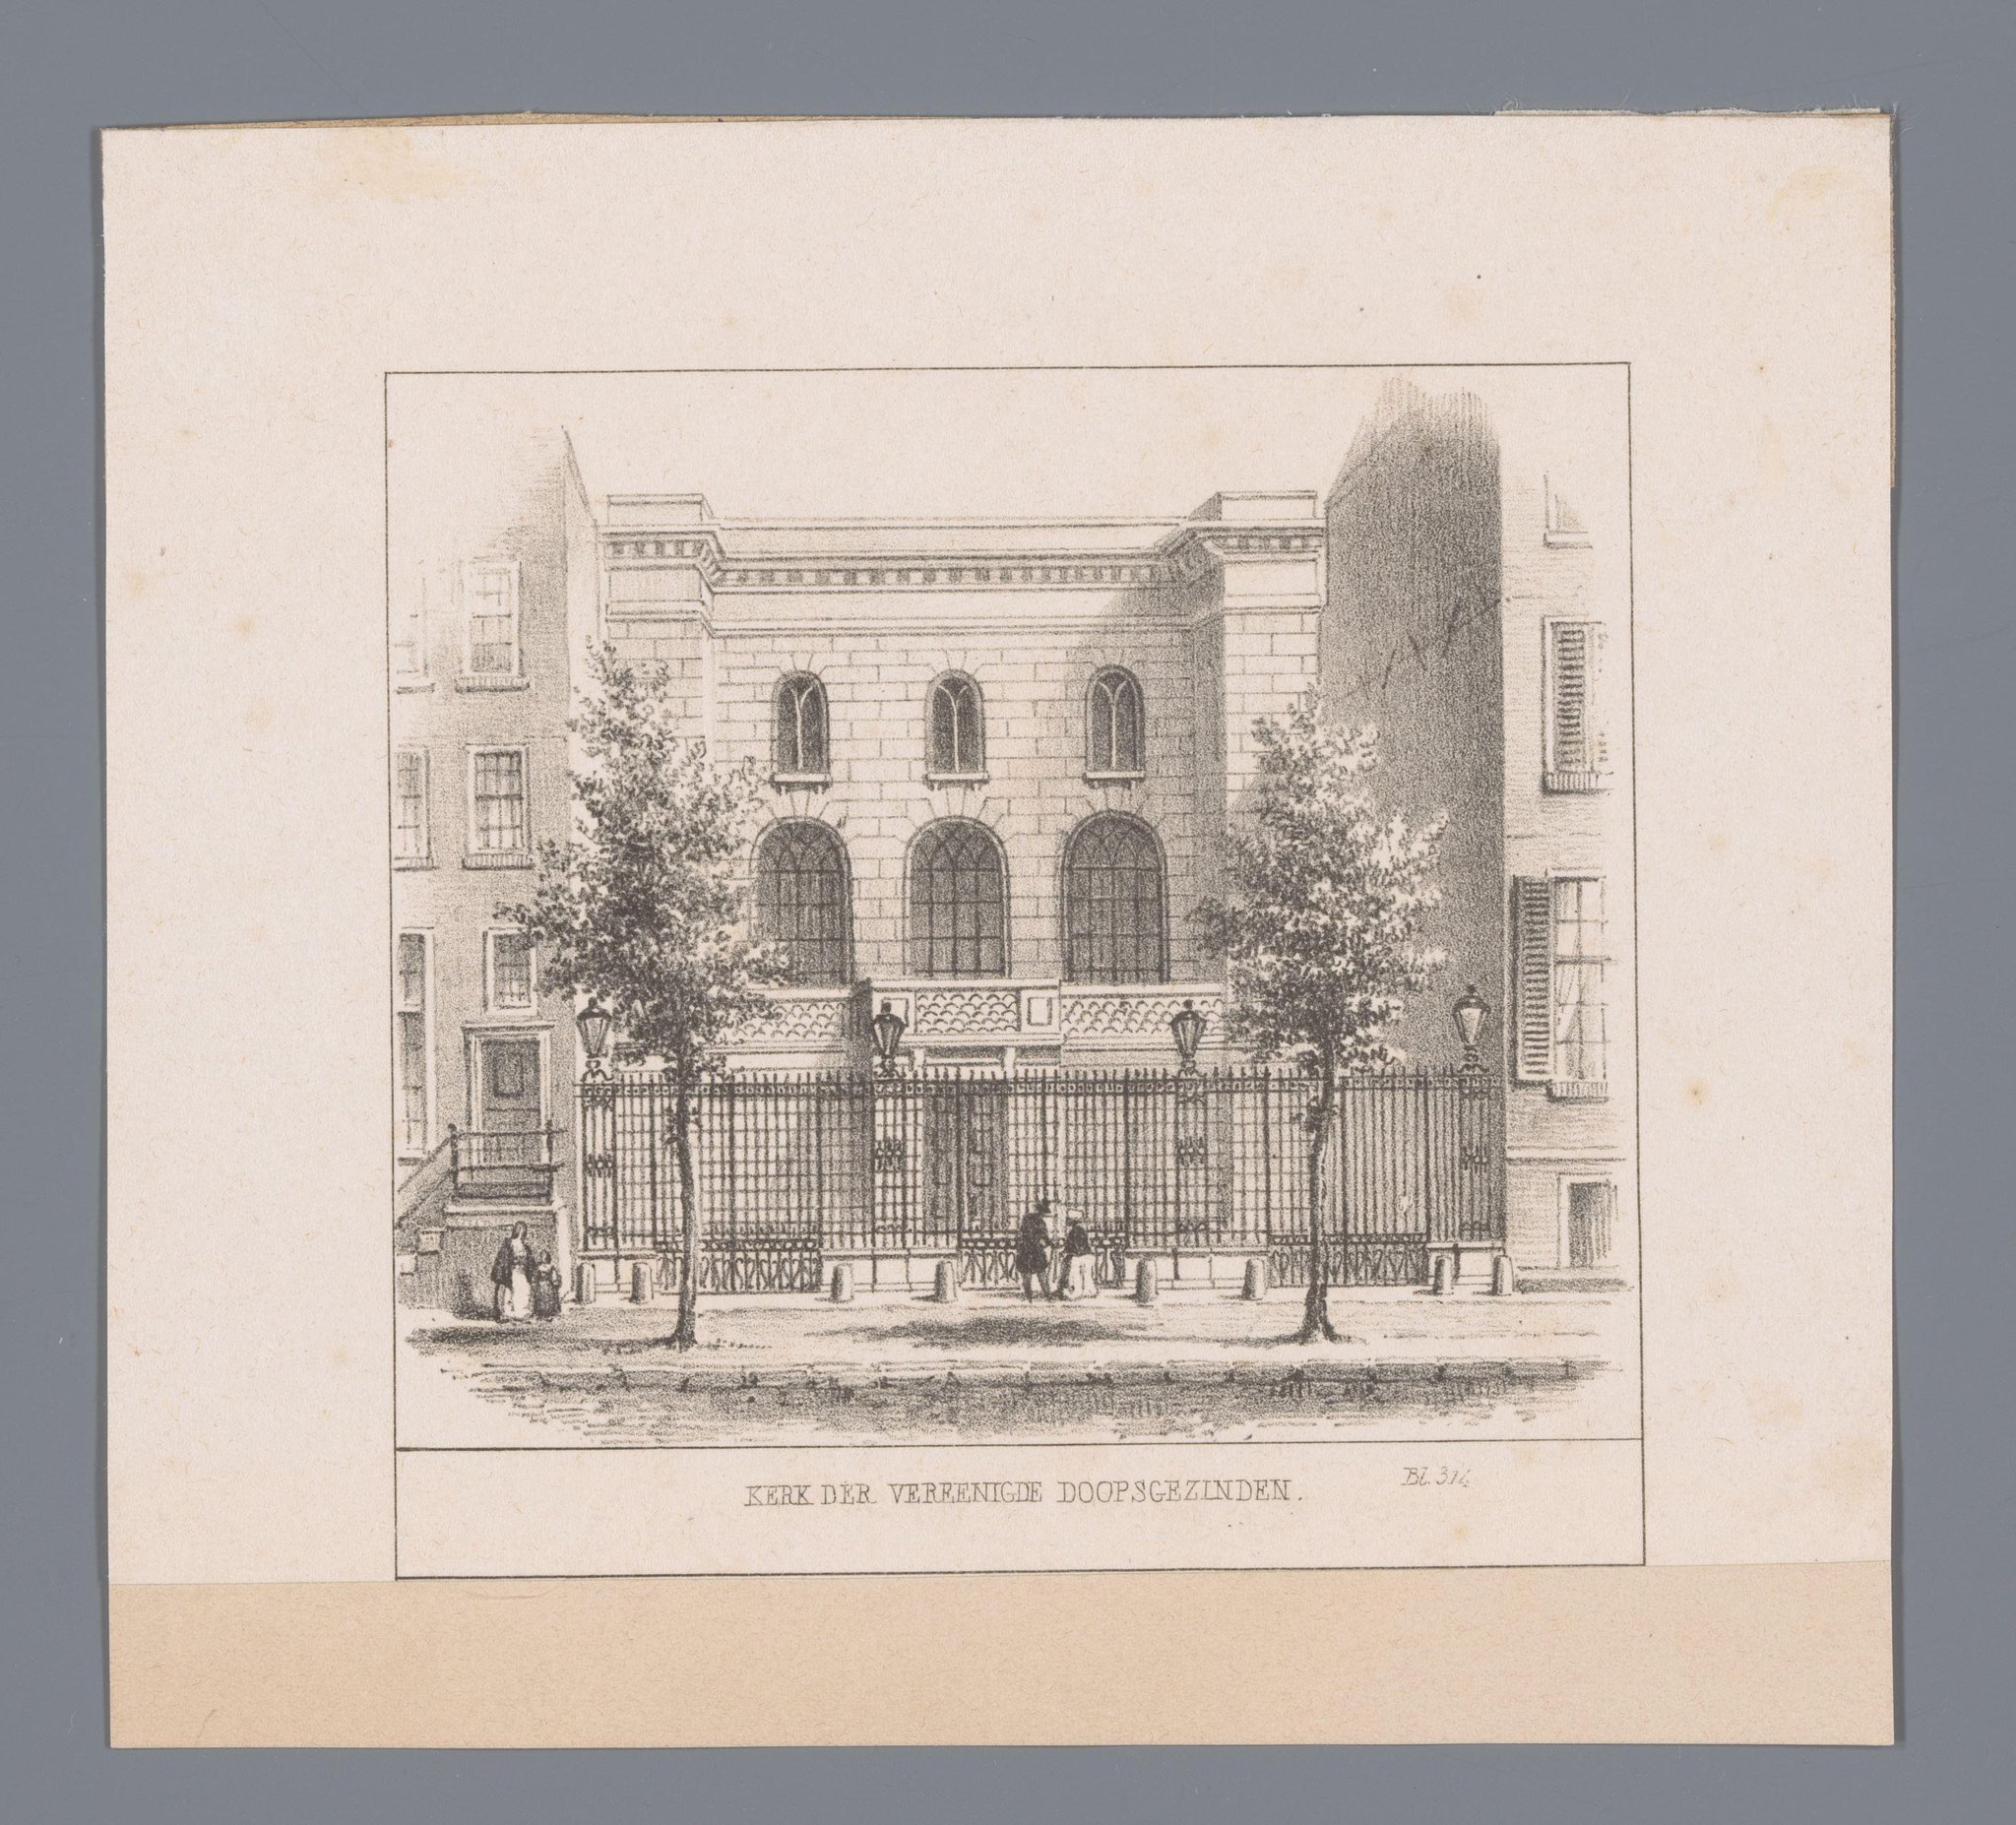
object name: book illustration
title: Gezicht op de Doopsgezinde Singelkerk gezien vanaf de Herengracht te Amsterdam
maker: johannes hilverdink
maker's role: draughtsman, painter, print maker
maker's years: 1813-1902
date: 1844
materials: paper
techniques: lithograph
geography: netherlands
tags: protestant churches and denominations (mennonites), church (exterior), city-view, and landscape with man-made constructions (+ city(-scape) with figures, staffage)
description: Prent uit: Vijver, Cornelis van der. Geschiedkundige Beschrijving der Stad Amsterdam (...). Amsterdam: Gebroeders Diederichs, 1844, dl. 1.